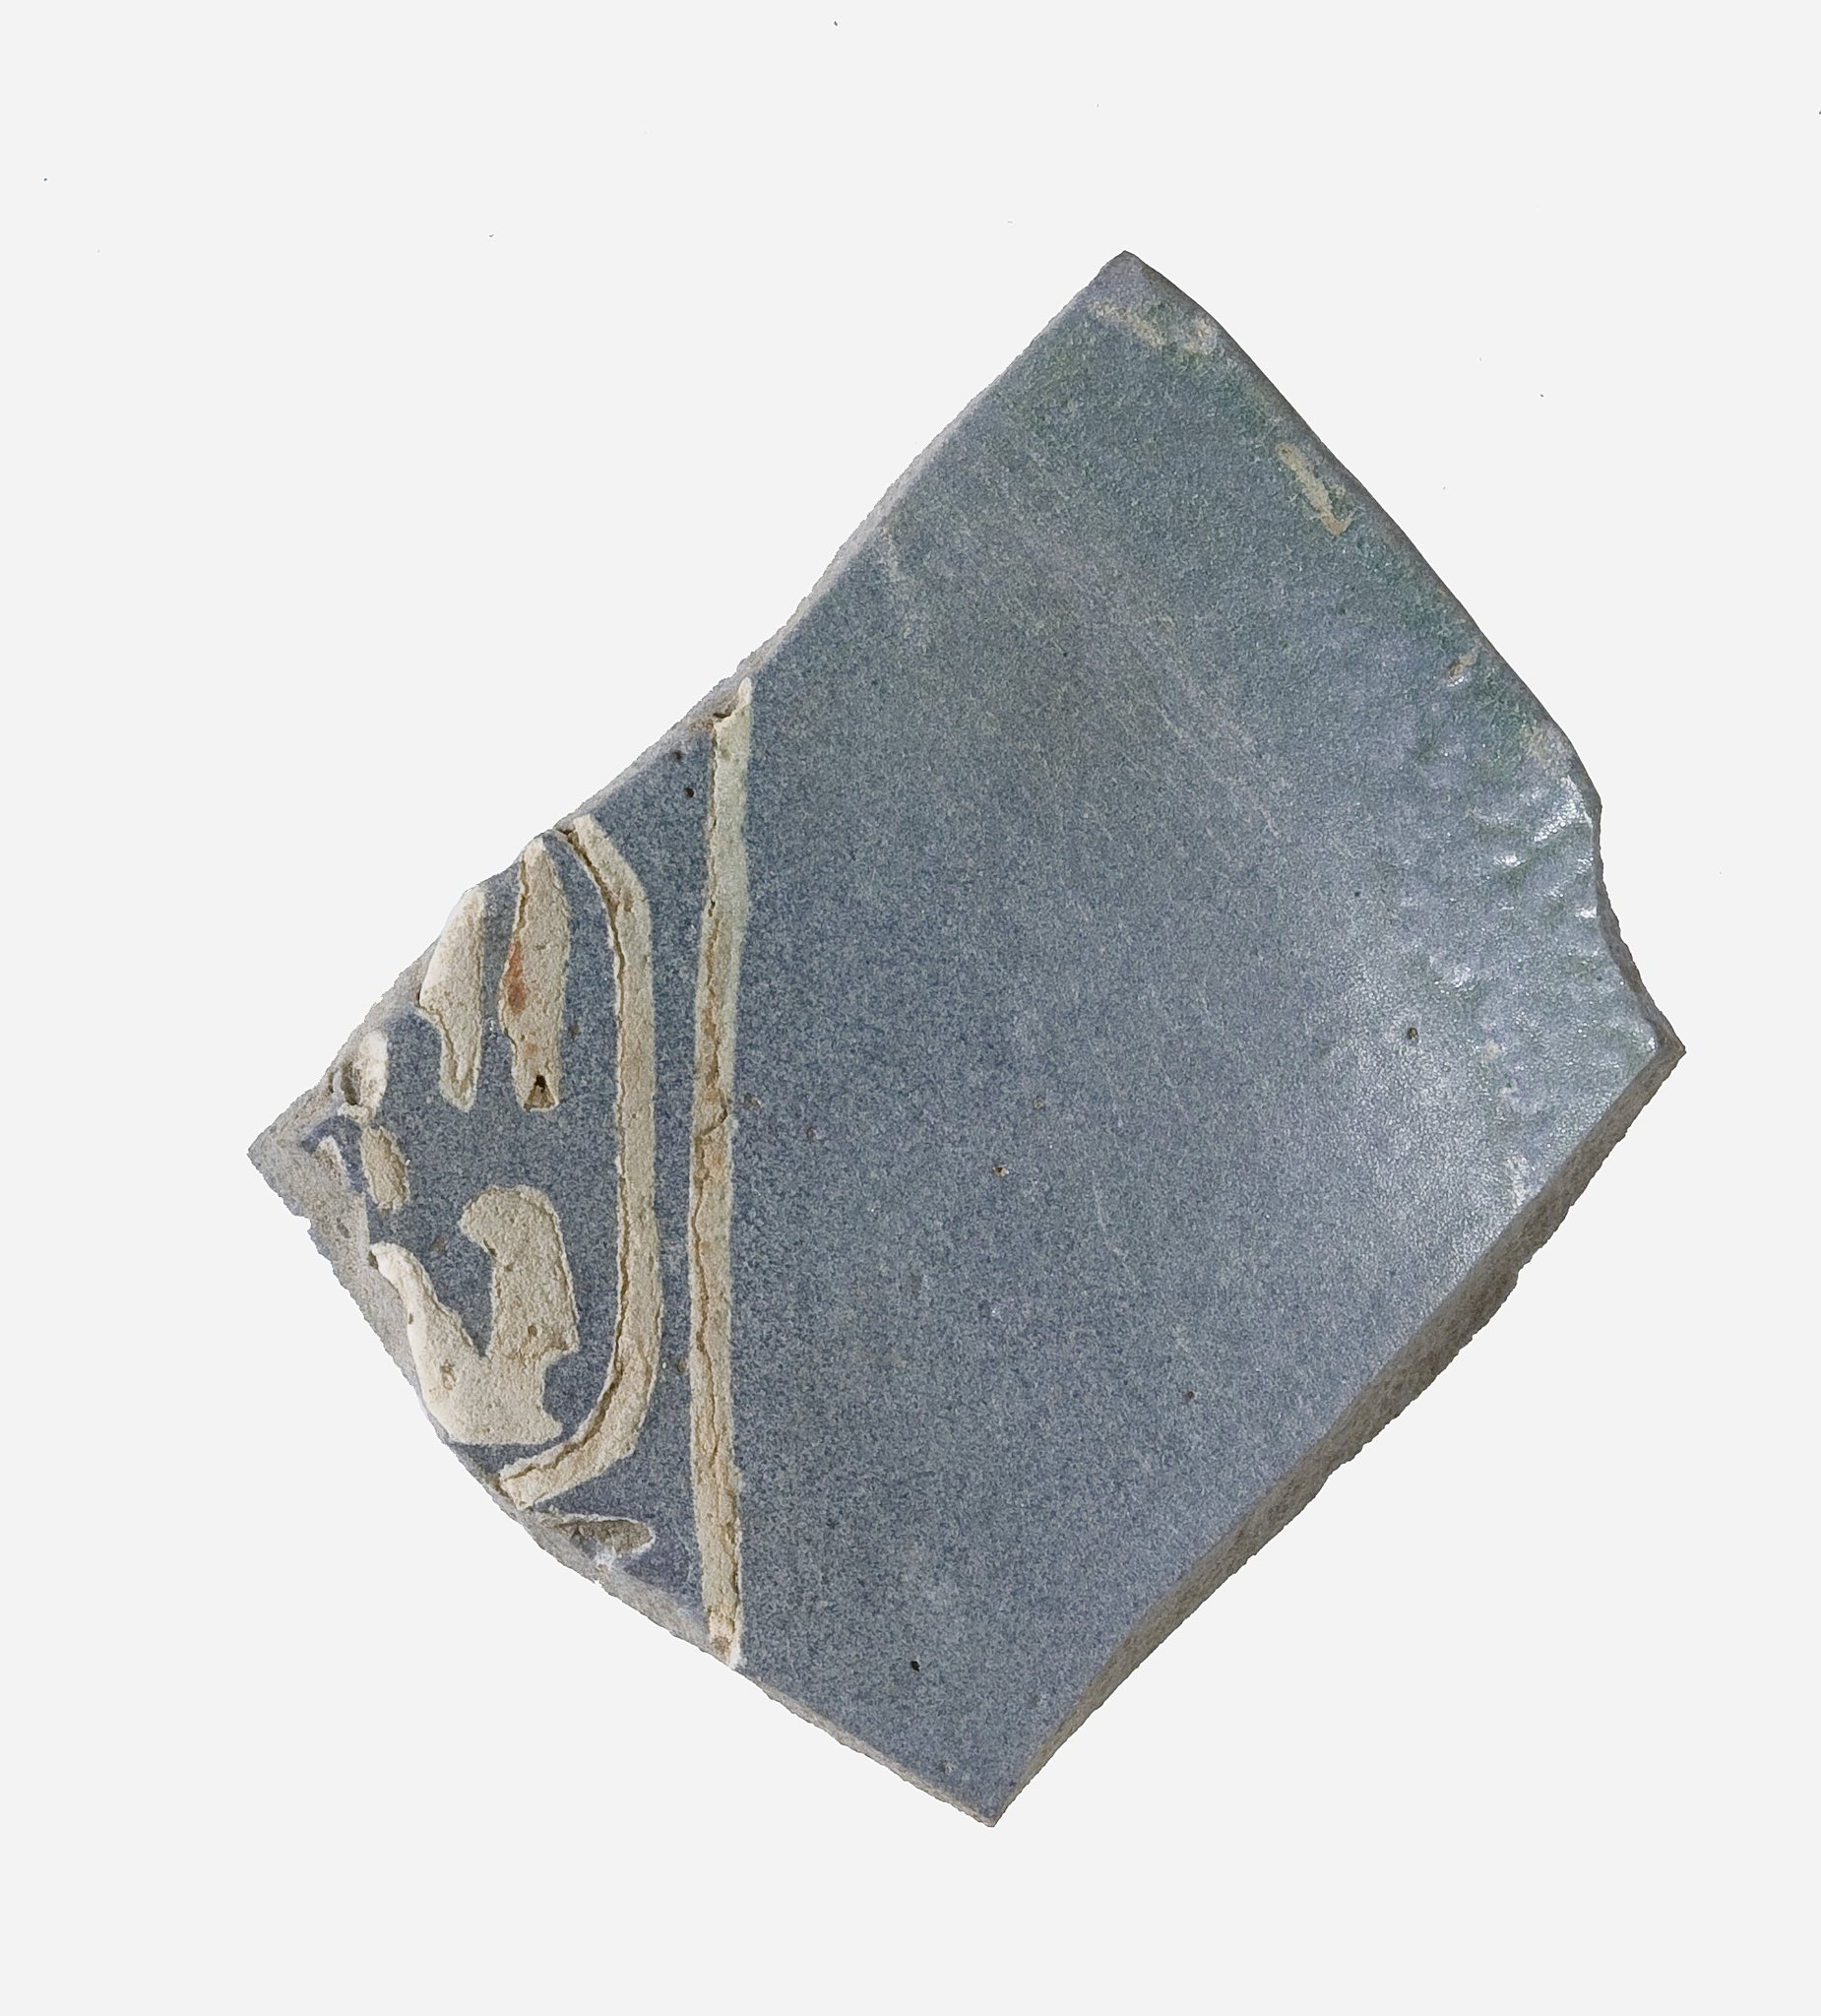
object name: dish fragment, tiye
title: Fragment of a Dish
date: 1390-1352 BCE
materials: faience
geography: egypt